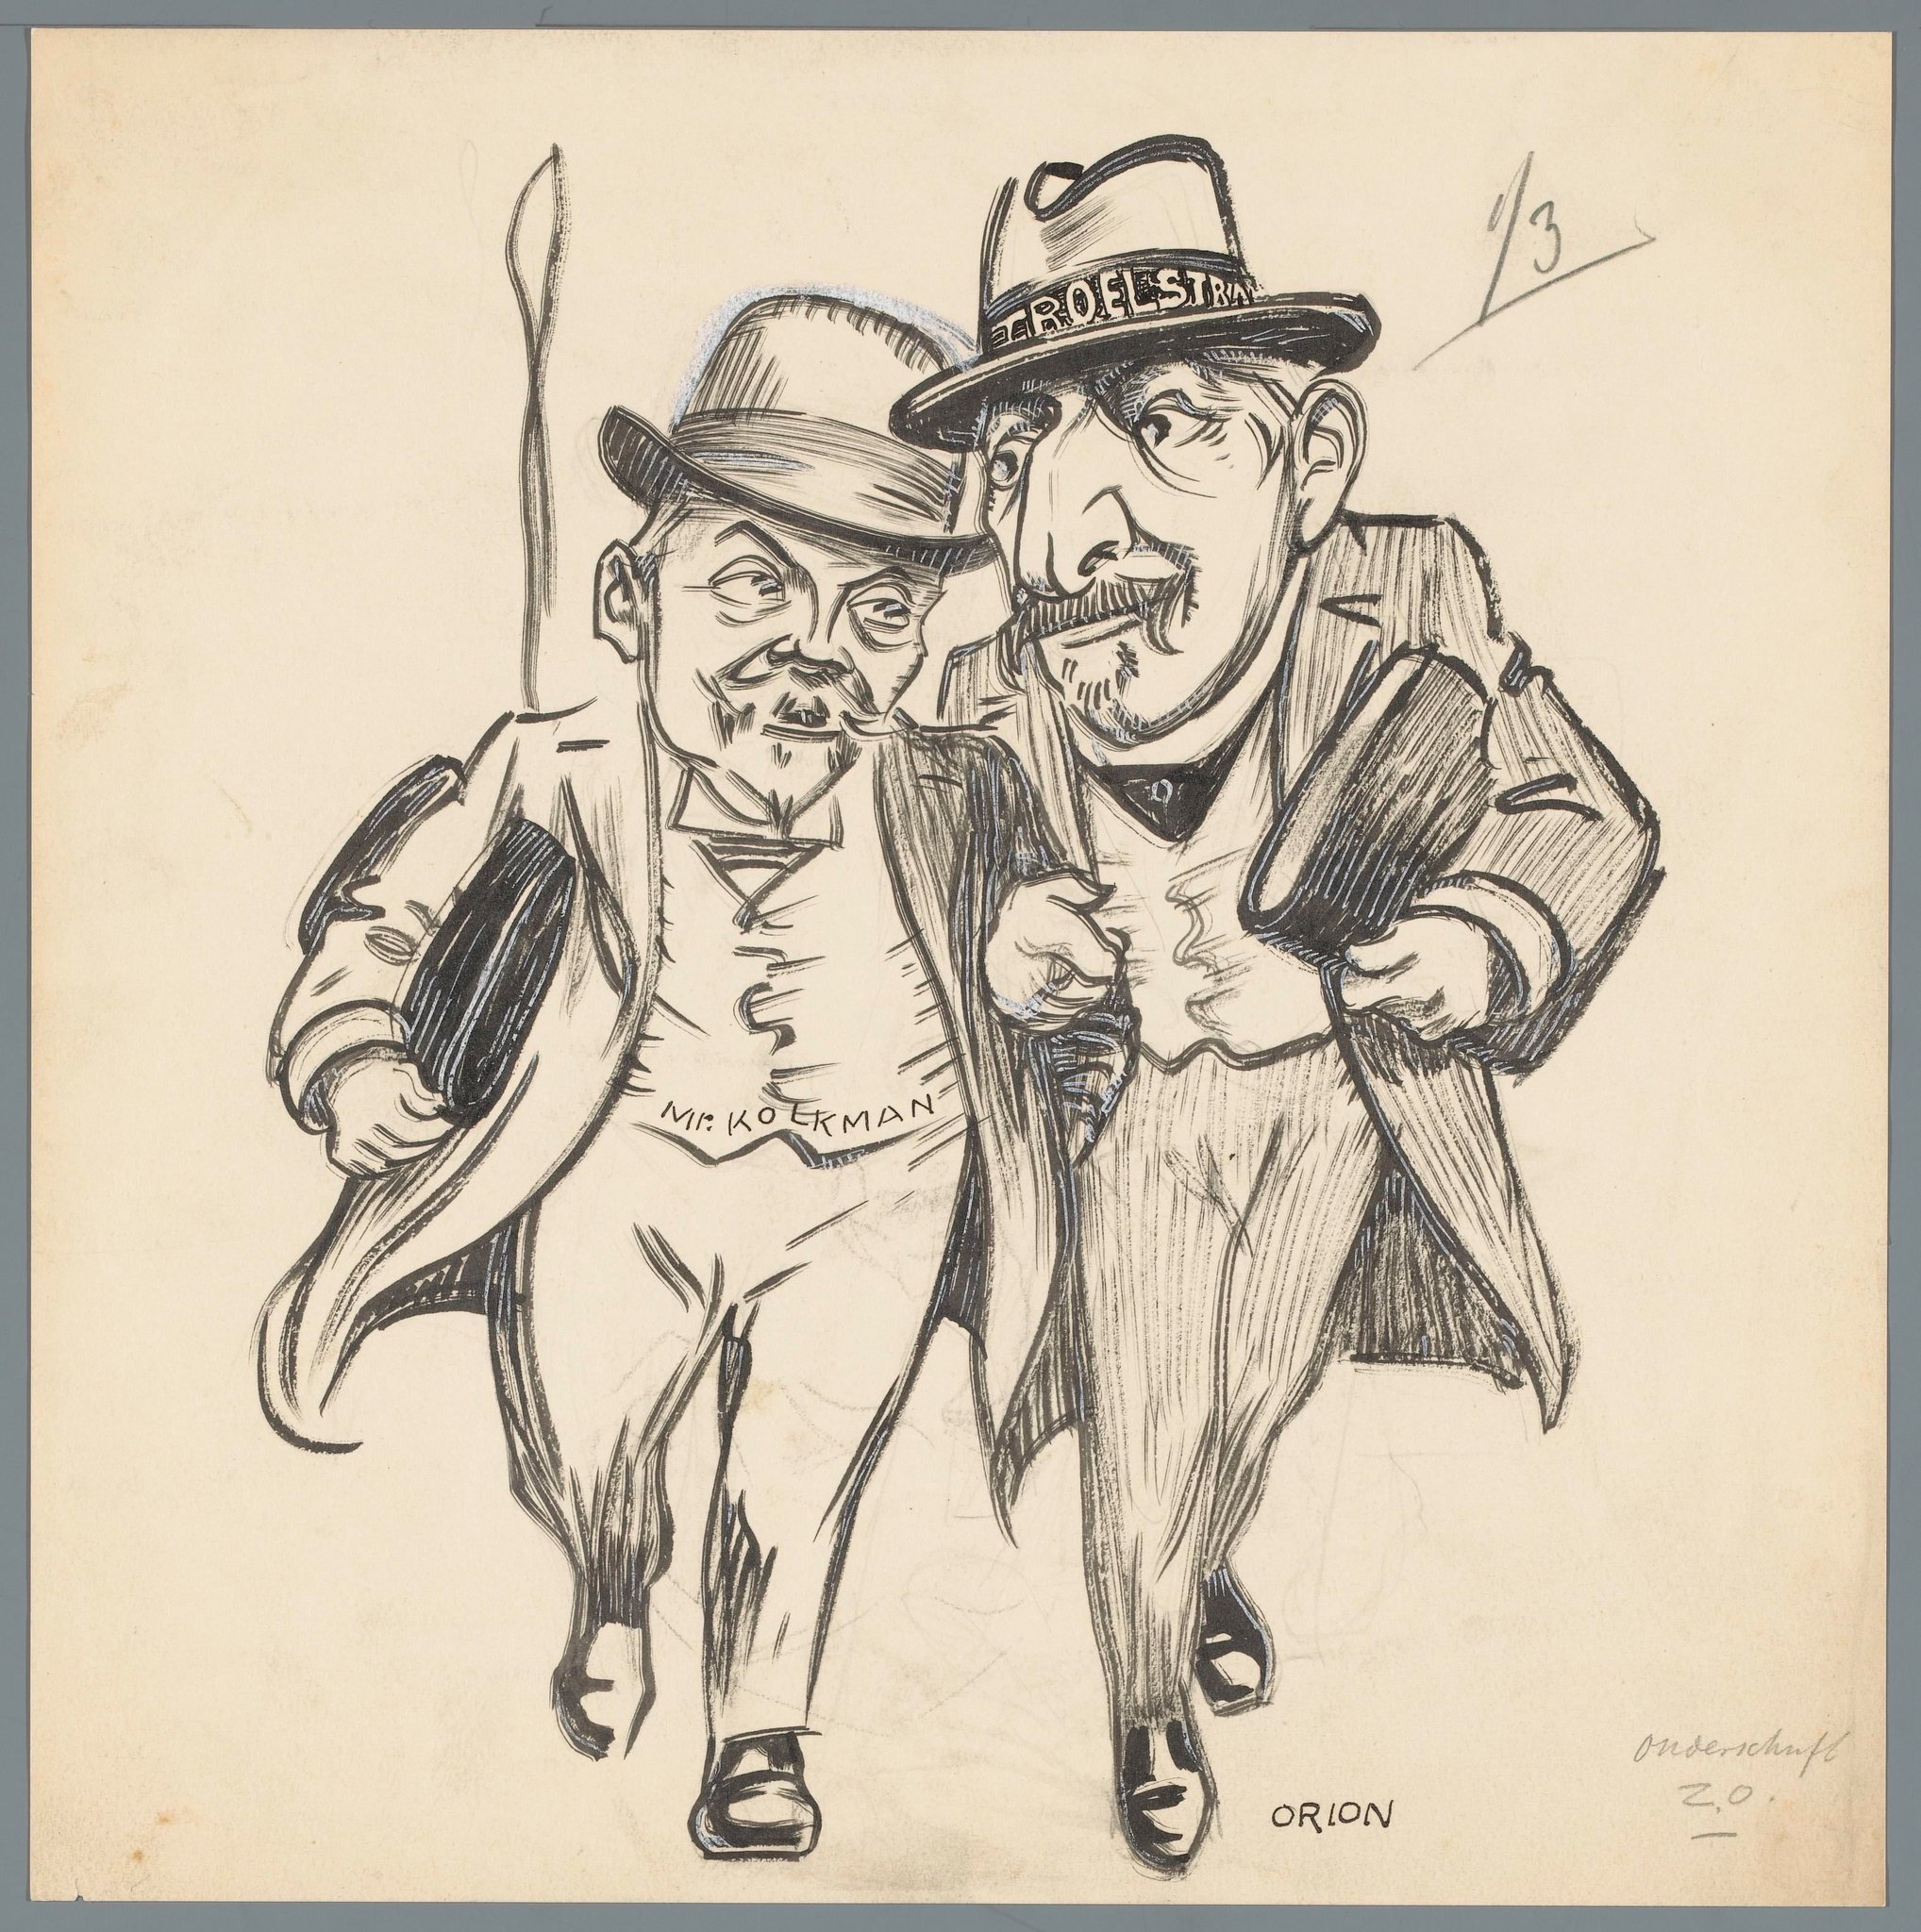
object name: cartoon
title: Romantische liefde bij de Grondwetsherziening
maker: patricq kroon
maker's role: draughtsman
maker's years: 1862-1941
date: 1916-1924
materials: ink, paint, paper, pencil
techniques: pen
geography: netherlands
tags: dordrecht, politician, political caricatures and satires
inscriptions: inscription: ‘Romantische liefde bij de Grondwetsherziening (opheffing Processieverbod) / Troelstyra en Kolkman (gearmd naar den brand) ...’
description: Troelstra en Kolkman lopen gearmd over straat, naar aanleiding van samenwerking bij de voorgenomen grondwetsherziening over de opheffing van het processieverbod. Ontwerp voor een politieke spotprent.